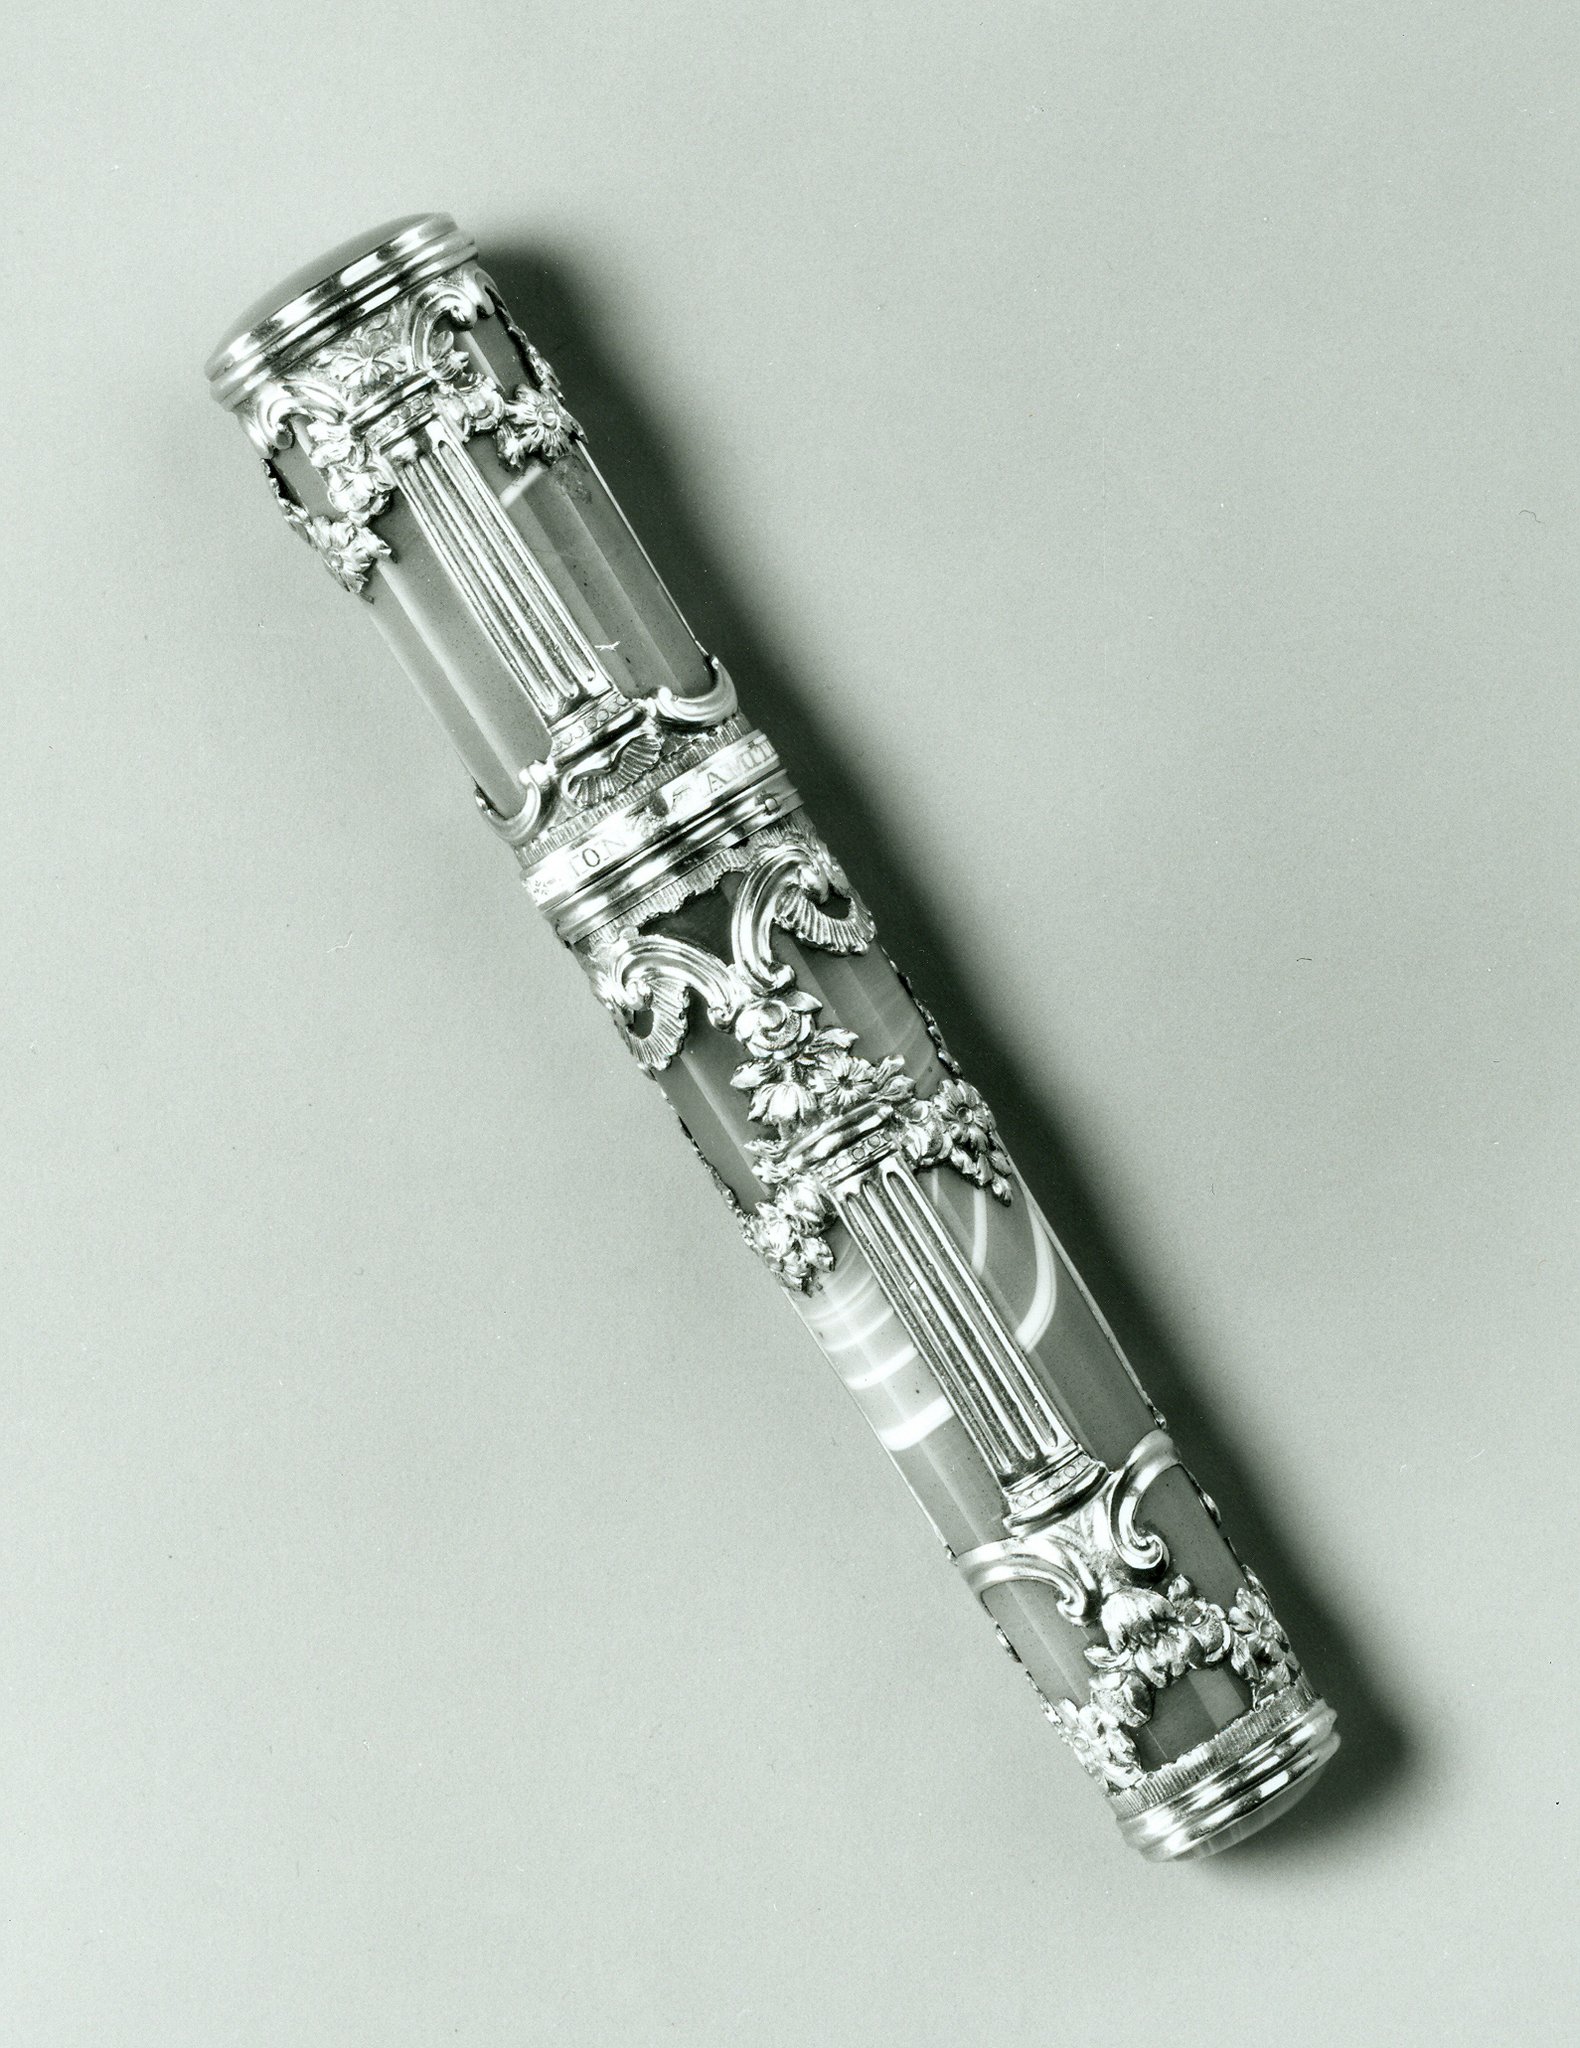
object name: étui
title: Etui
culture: british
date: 1765-1770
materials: stone, gold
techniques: chasing